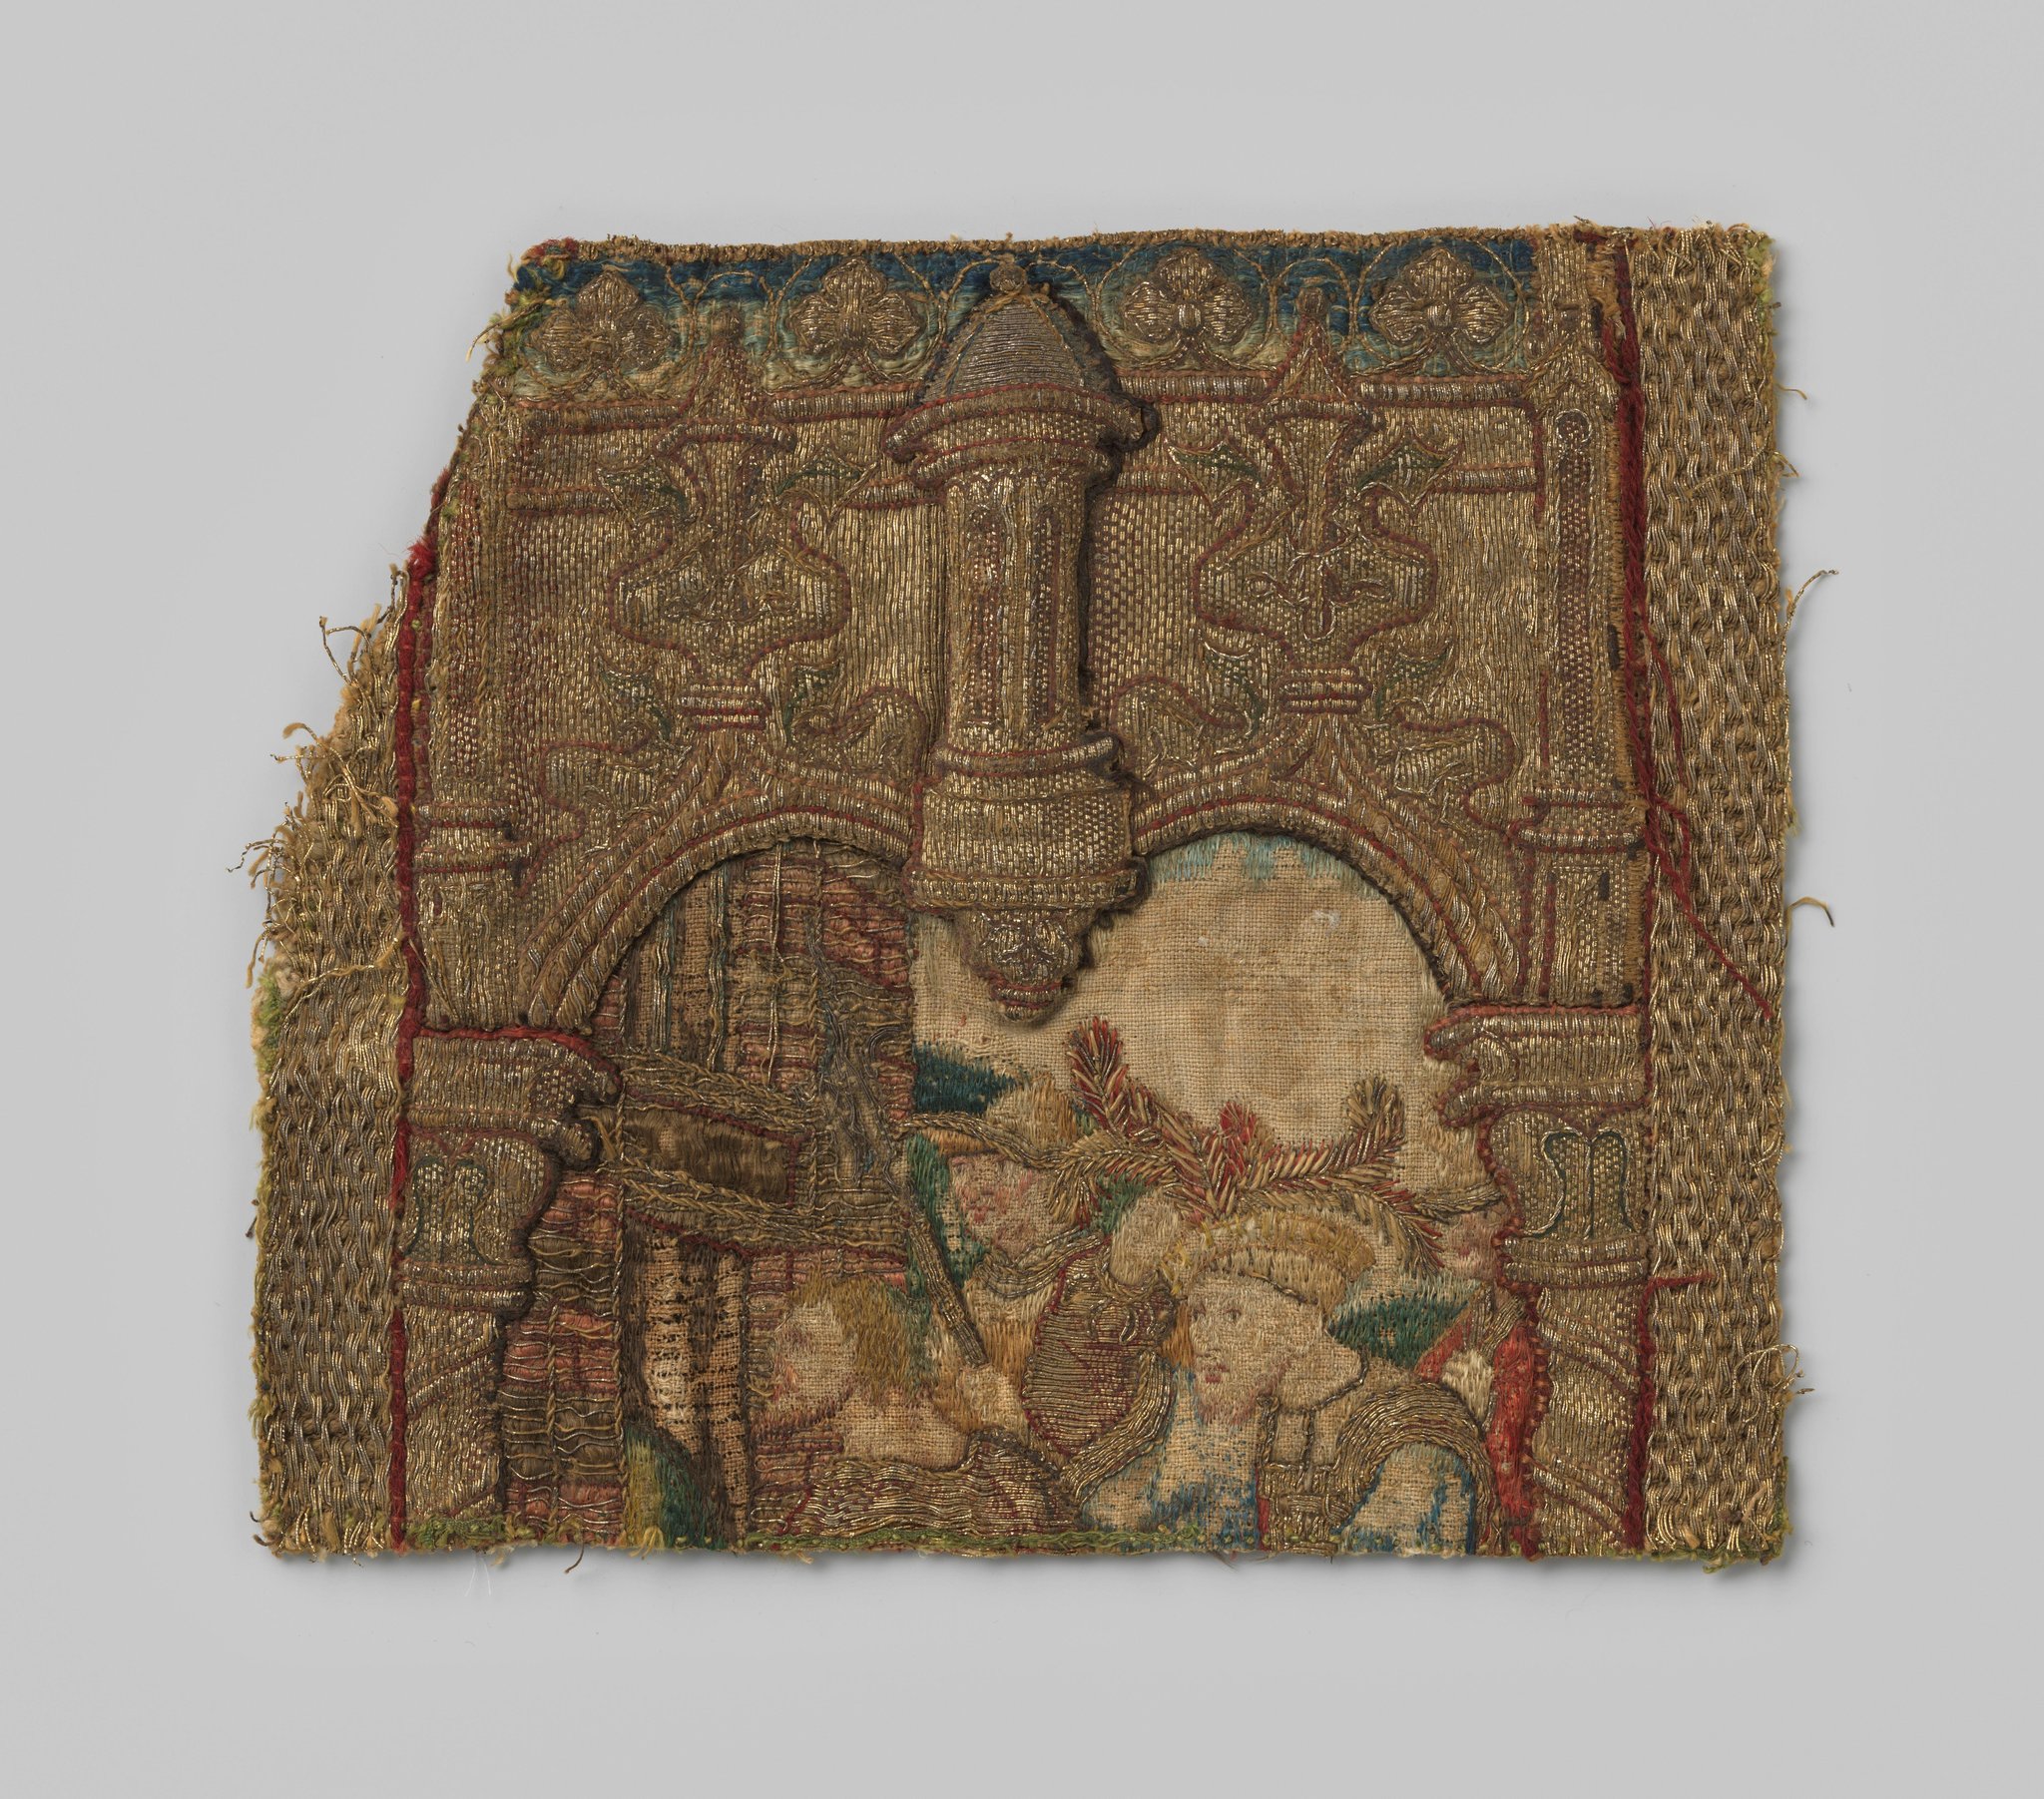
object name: aurifries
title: Fragment van een aurifries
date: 1510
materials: textile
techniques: embroidered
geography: netherlands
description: Fragment van een aurifries, met borduurwerk. Het fragment heeft een afbeelding van laat gotische architectuur met Johannes de Doper in de kerker.